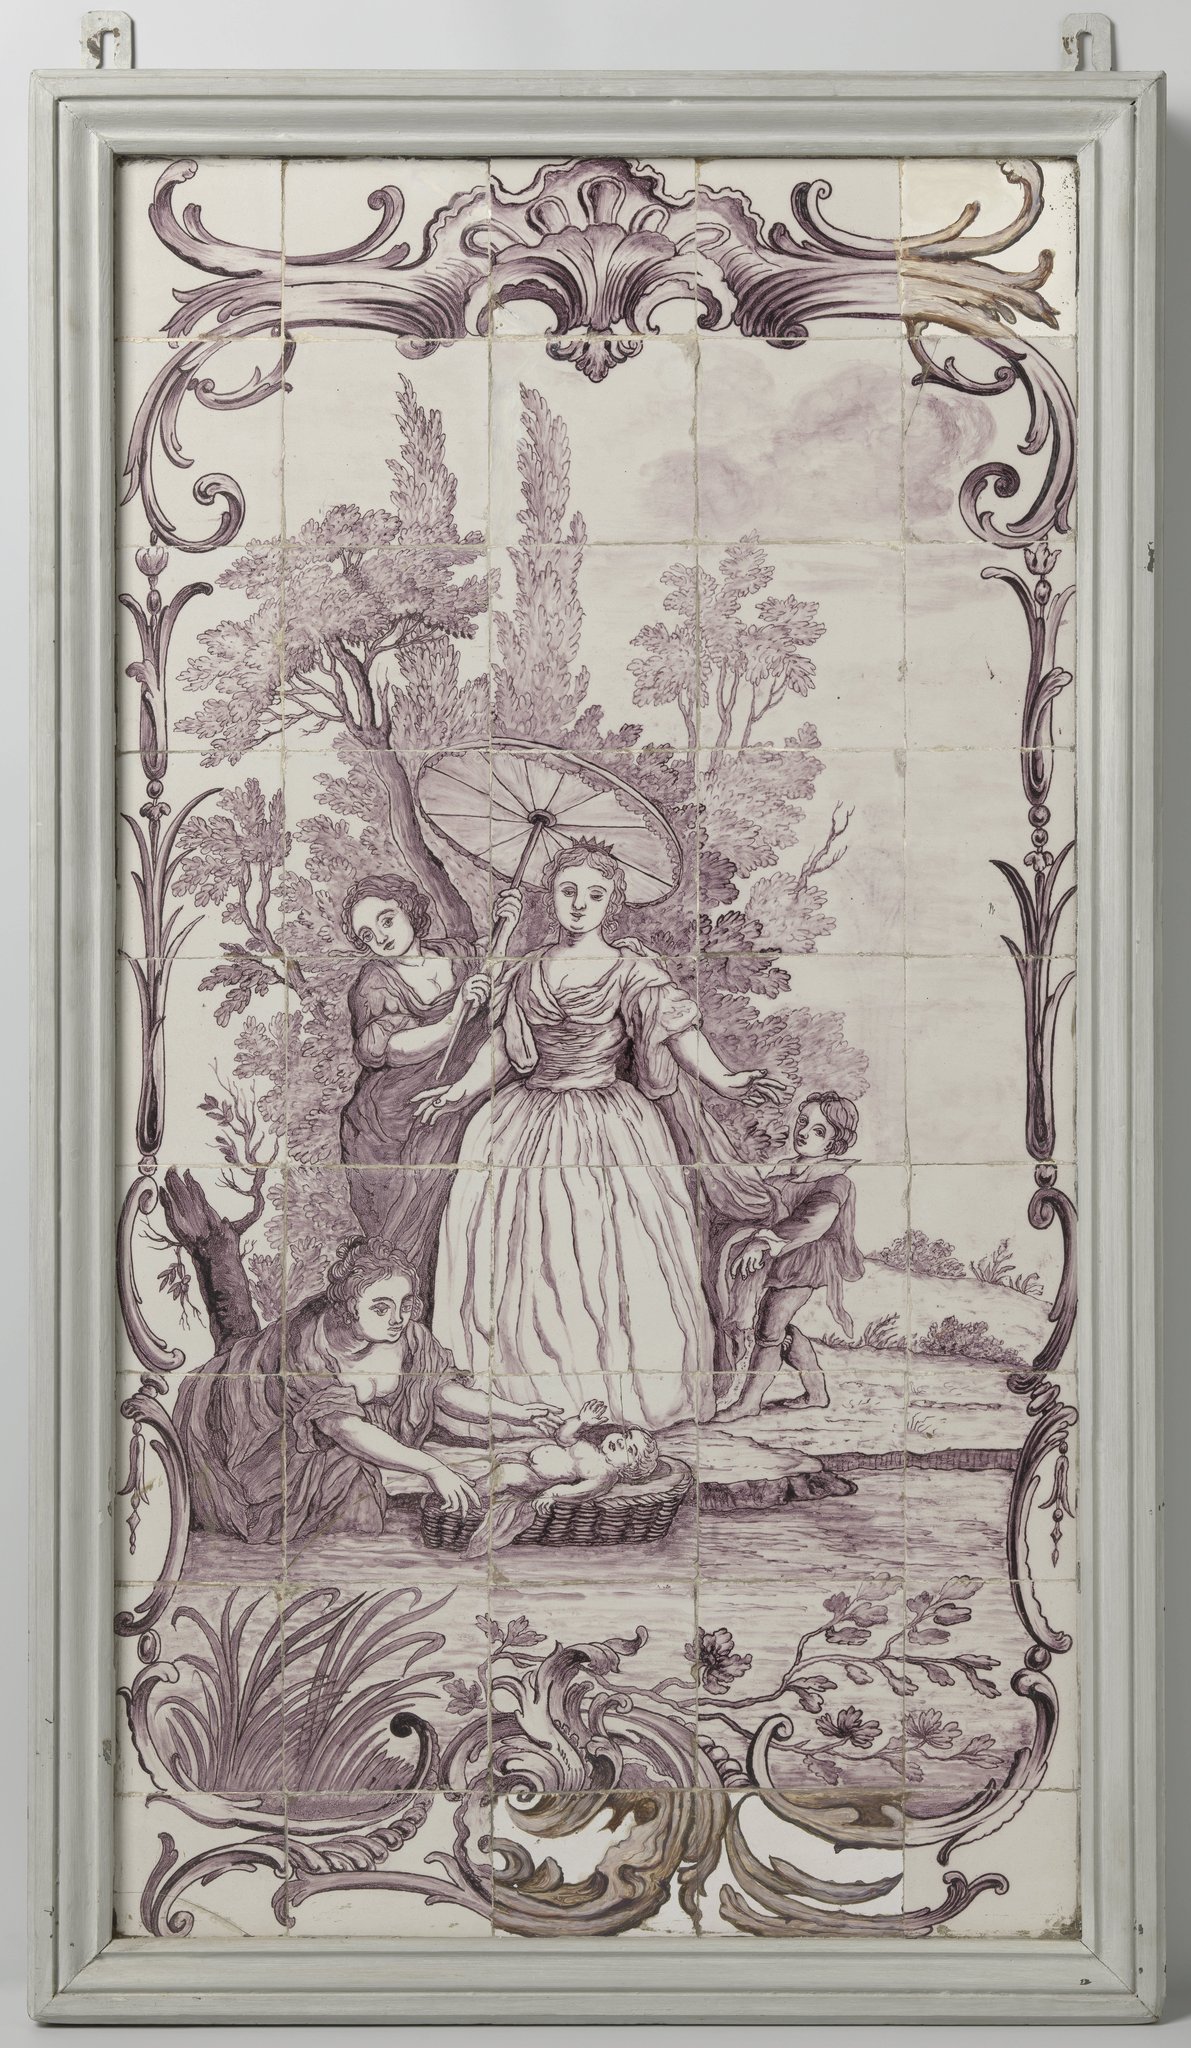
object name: tile tableau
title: tegeltableau van 45 tegels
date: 1760-1780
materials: earthenware, glaze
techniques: maiolica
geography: rotterdam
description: Tegeltableau van 45 tegels (9 x 5) met een paars geschilderde bijbelse voorstelling van de vinding van Mozes. In het midden staat een vrouw langs de oever en voor haar drijft in het water een mandje met een kindje. De voostelling is omgeven door rococo ornament.